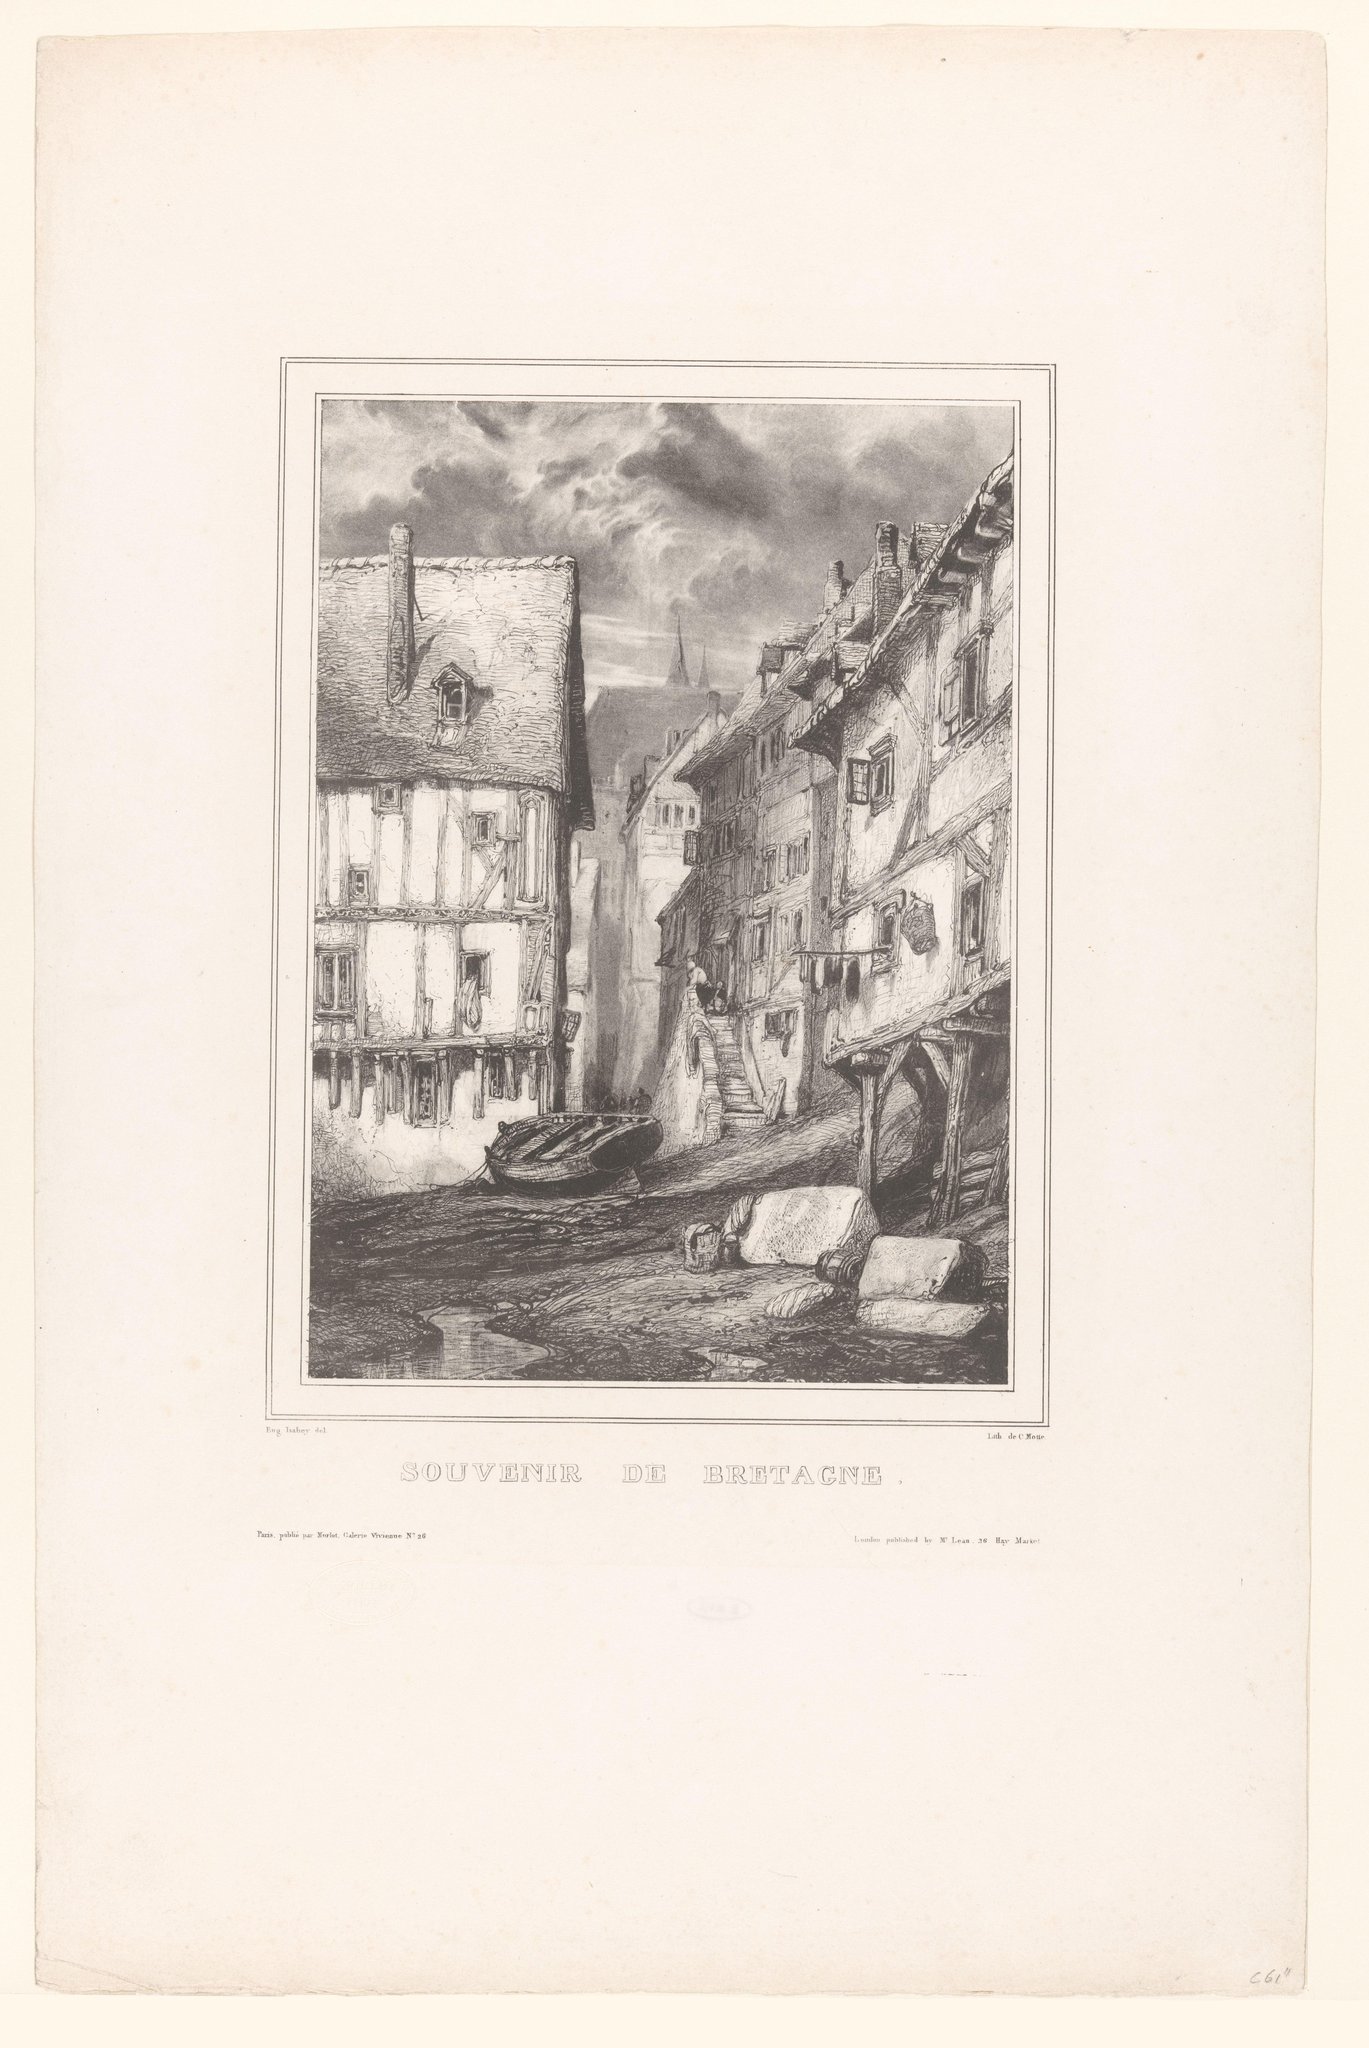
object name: print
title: Souvenir de Bretagne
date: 1832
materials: paper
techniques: lithograph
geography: paris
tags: rowing-boat, canoe, etc., civic architecture; edifices; dwellings, canals, waters (in city) (+ city(-scape) with figures, staffage)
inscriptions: collector's mark: Lugt 2228a, check stamp: Lugt 1826b